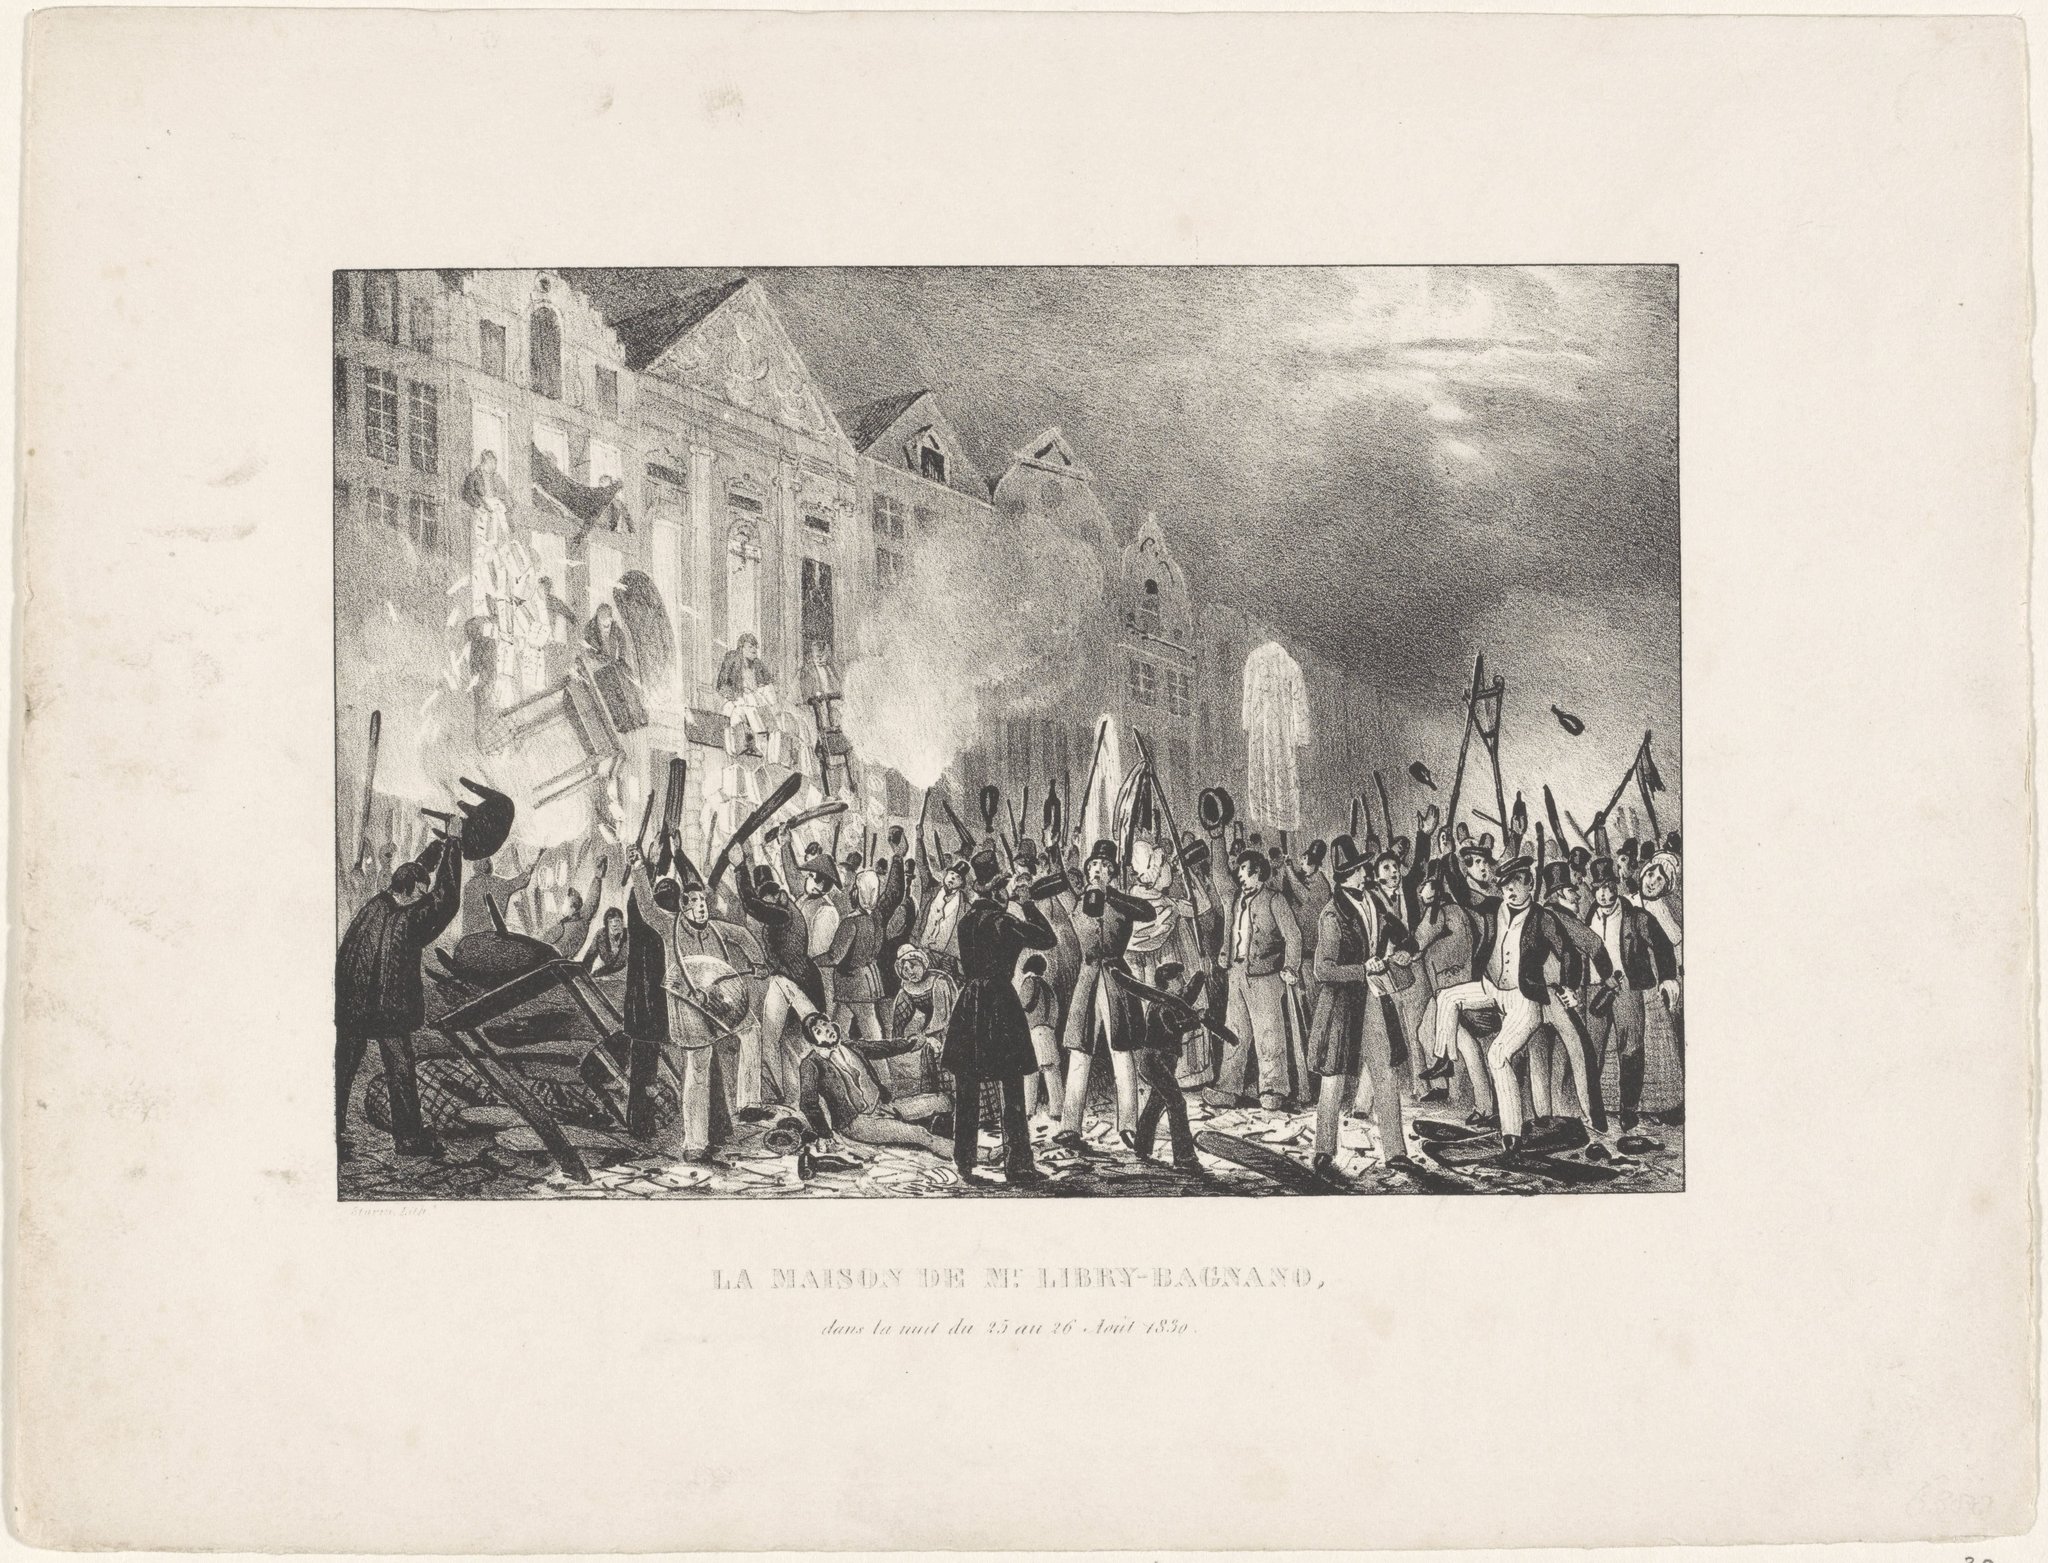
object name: print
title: Prenten toegevoegd aan de serie Evénemens de Bruxelles, Anvers (...) (1831)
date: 1830-1831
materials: paper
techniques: lithograph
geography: brussels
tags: printer, publisher, plundering ~ riot, brussels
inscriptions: collector's mark: Lugt 2228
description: Plundering van het huis van de uitgever George Libry, graaf van Bagnano, te Brussel in de nacht van 25 op 26 augustus 1830. Onderdeel van een groep van prenten uit verschillende andere series verwant aan de platen in het recueil over de gebeurtenissen tijdens de Belgische Revolutie in Brussel, Antwerpen en andere steden in de periode 25 augustus 1830 tot 27 maart 1831.